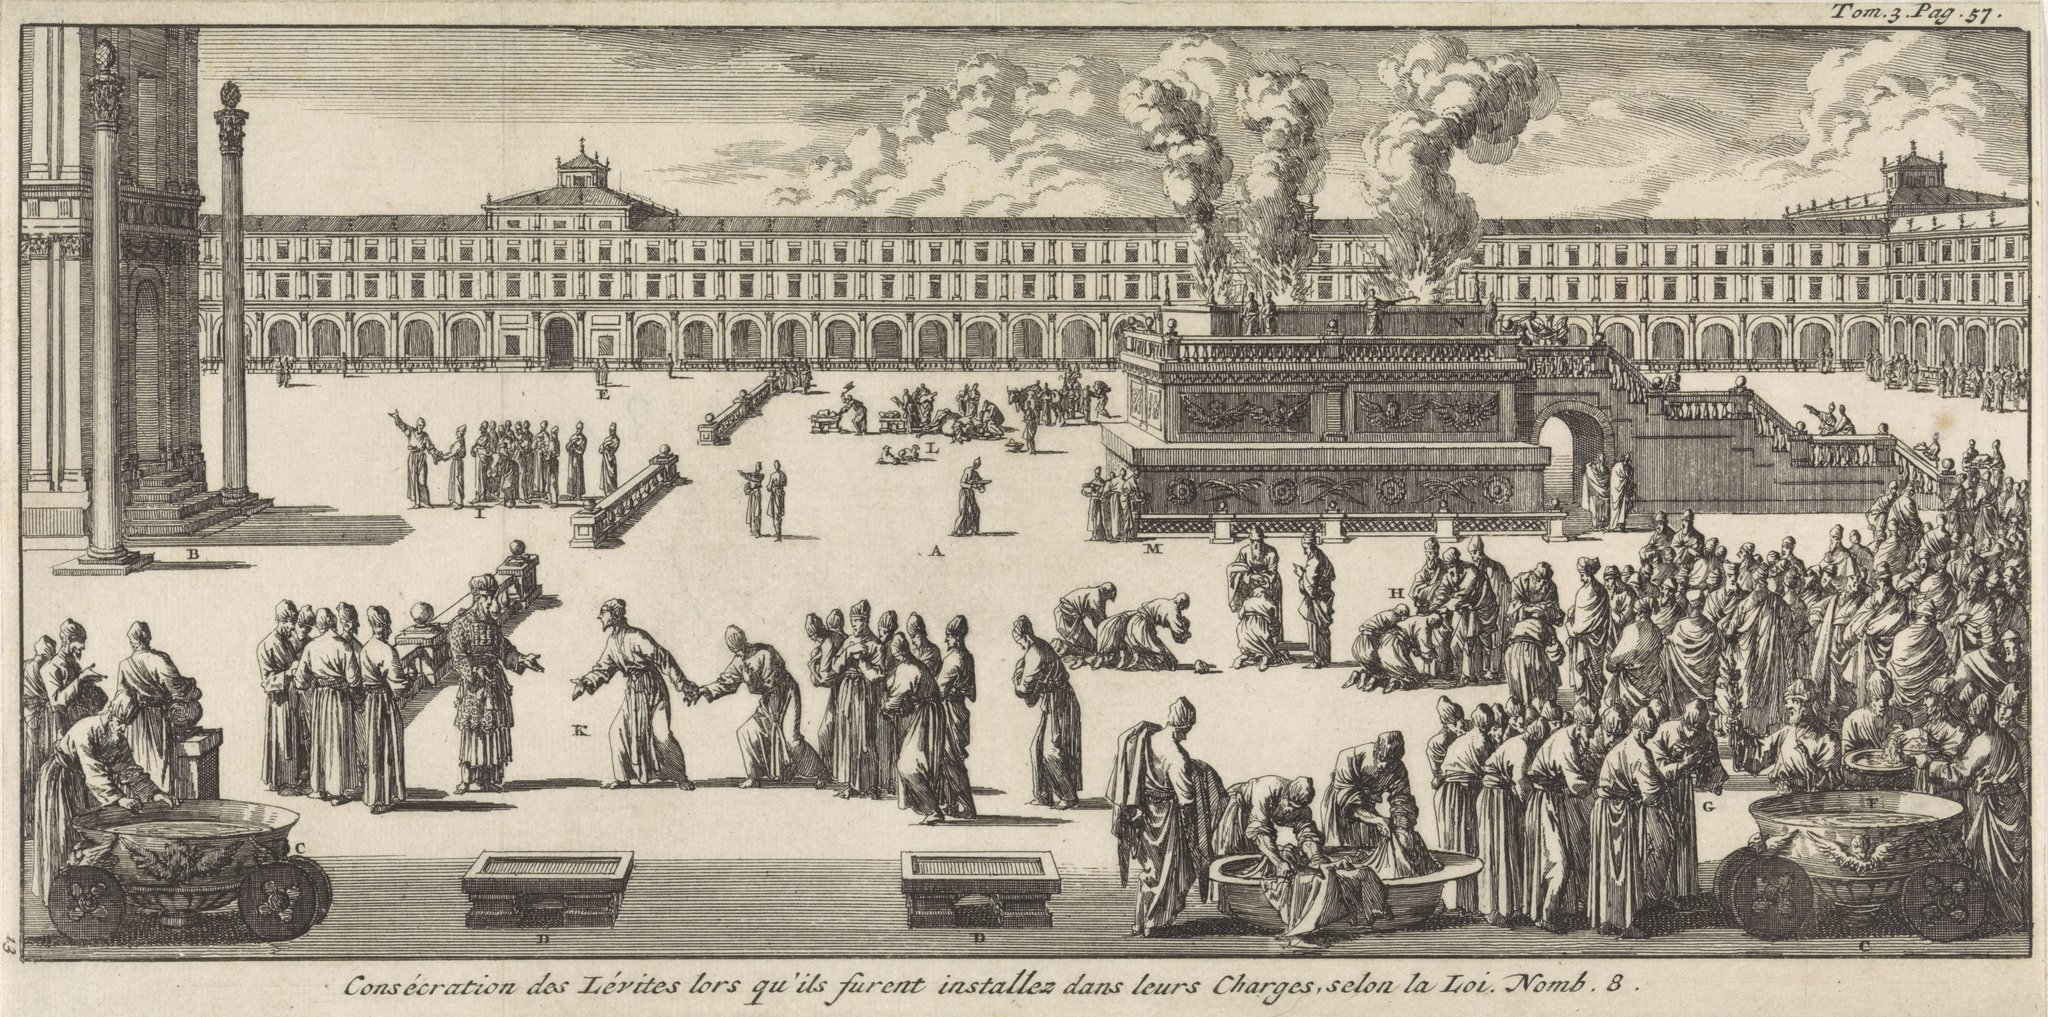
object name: book illustration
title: Wijding van de Levieten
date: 1705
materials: paper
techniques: etching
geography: amsterdam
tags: the levites are appointed to serve the priests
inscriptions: collector's mark: Lugt 2228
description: Illustratie uit: Cunaeus, Petrus. La republique des Hebreux, 3 delen. Amsterdam: Pieter Mortier, 1705, dl. III, p. 57.